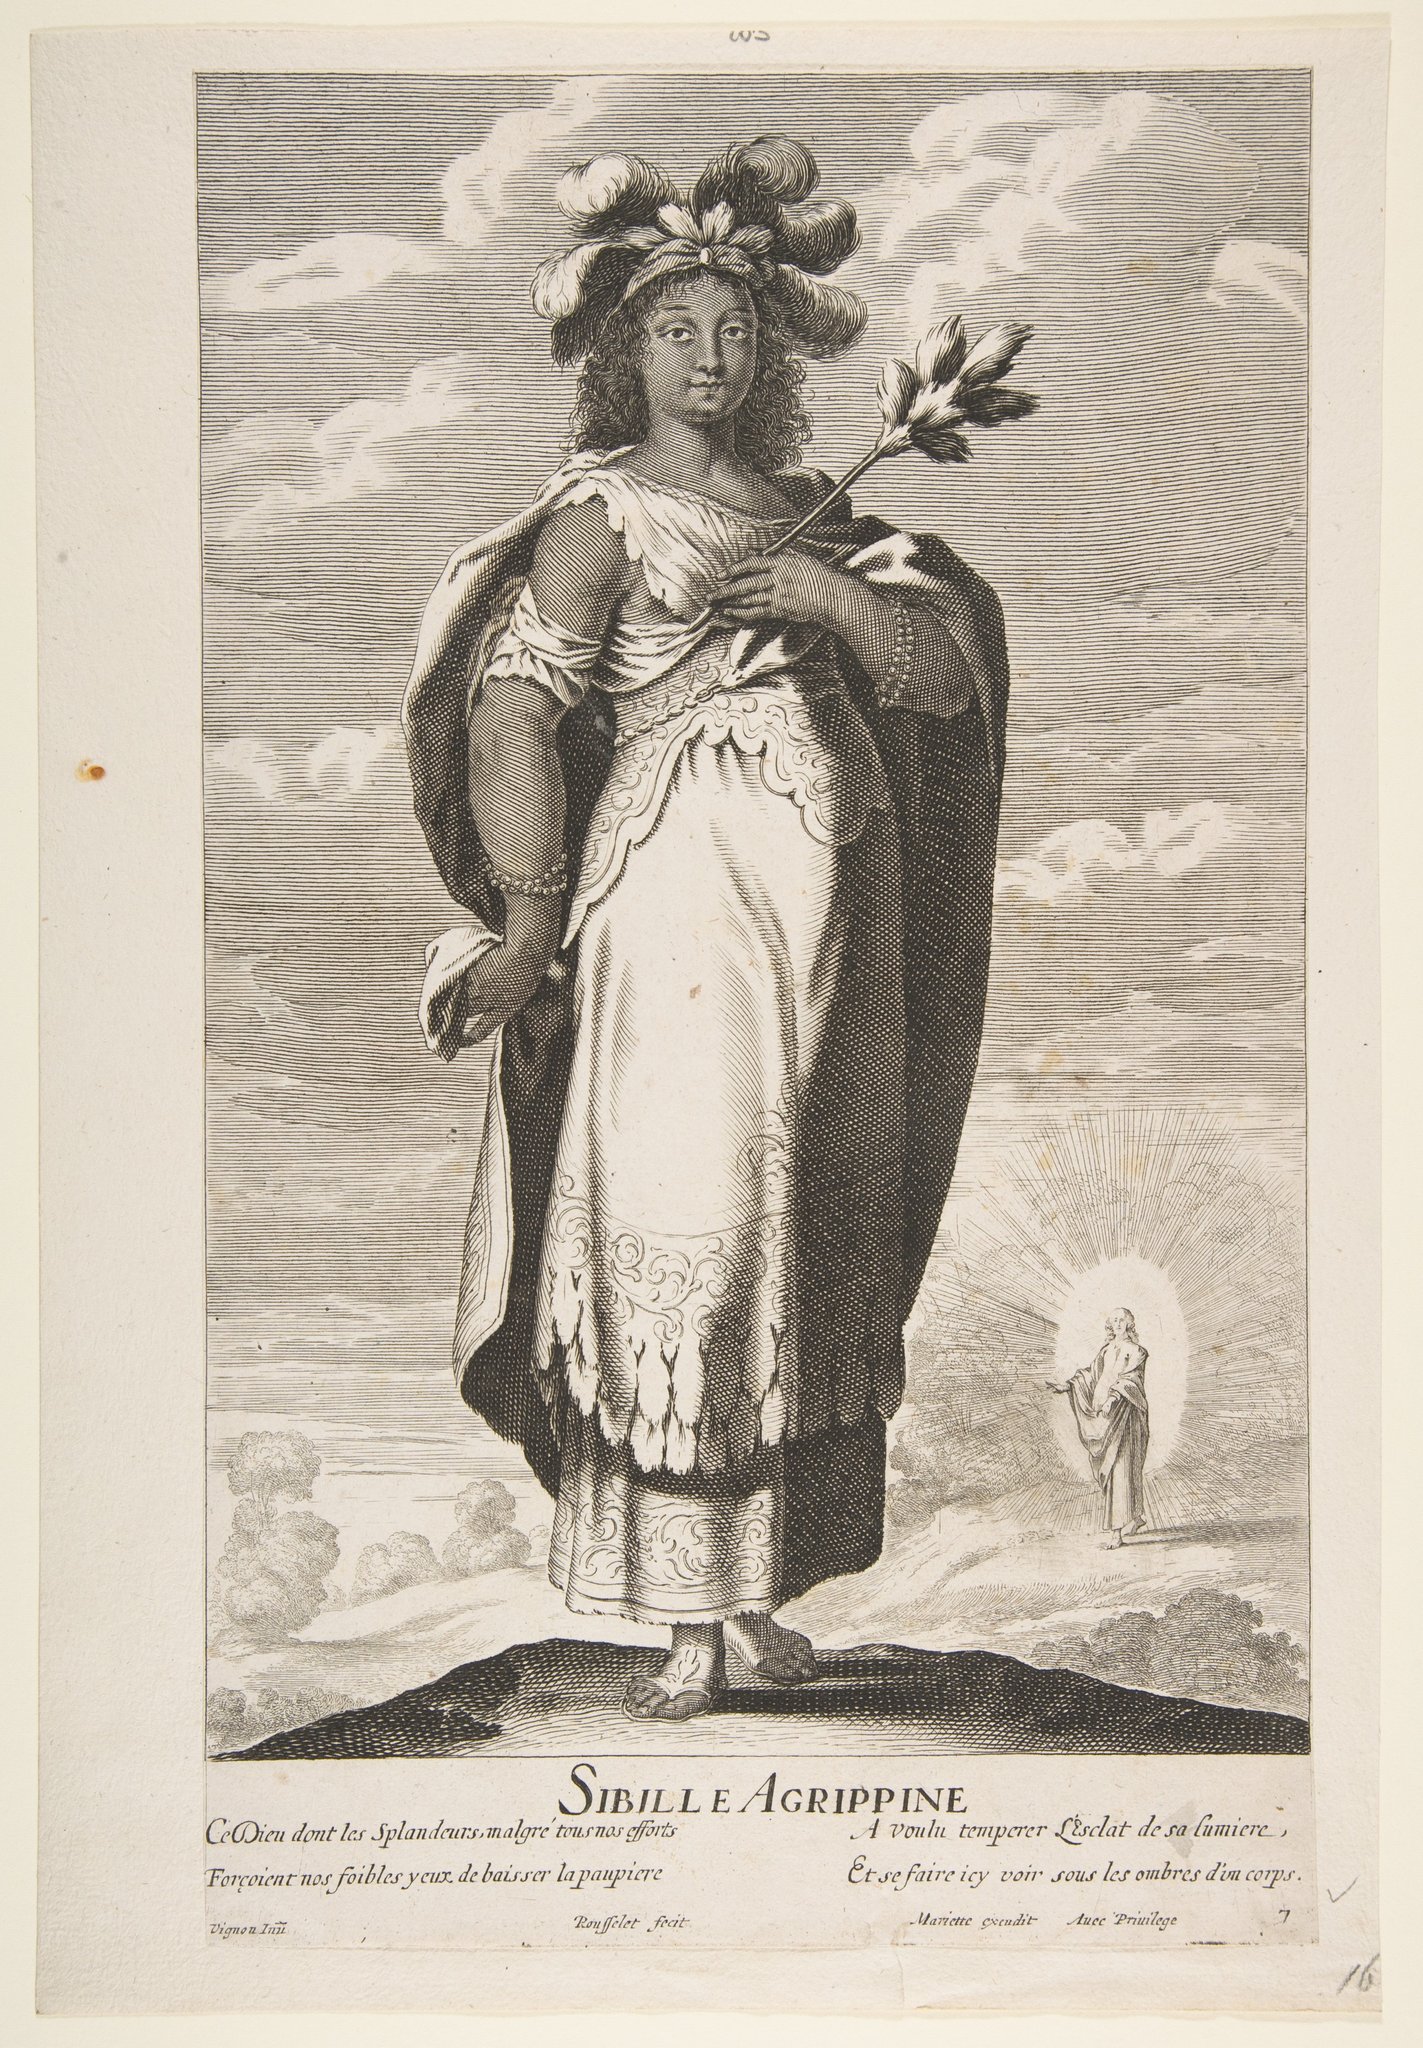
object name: print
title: Sibylle Agrippa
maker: gilles rousselet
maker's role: artist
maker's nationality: french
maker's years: 1614-1686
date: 1635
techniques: engraving, etching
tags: sibyl